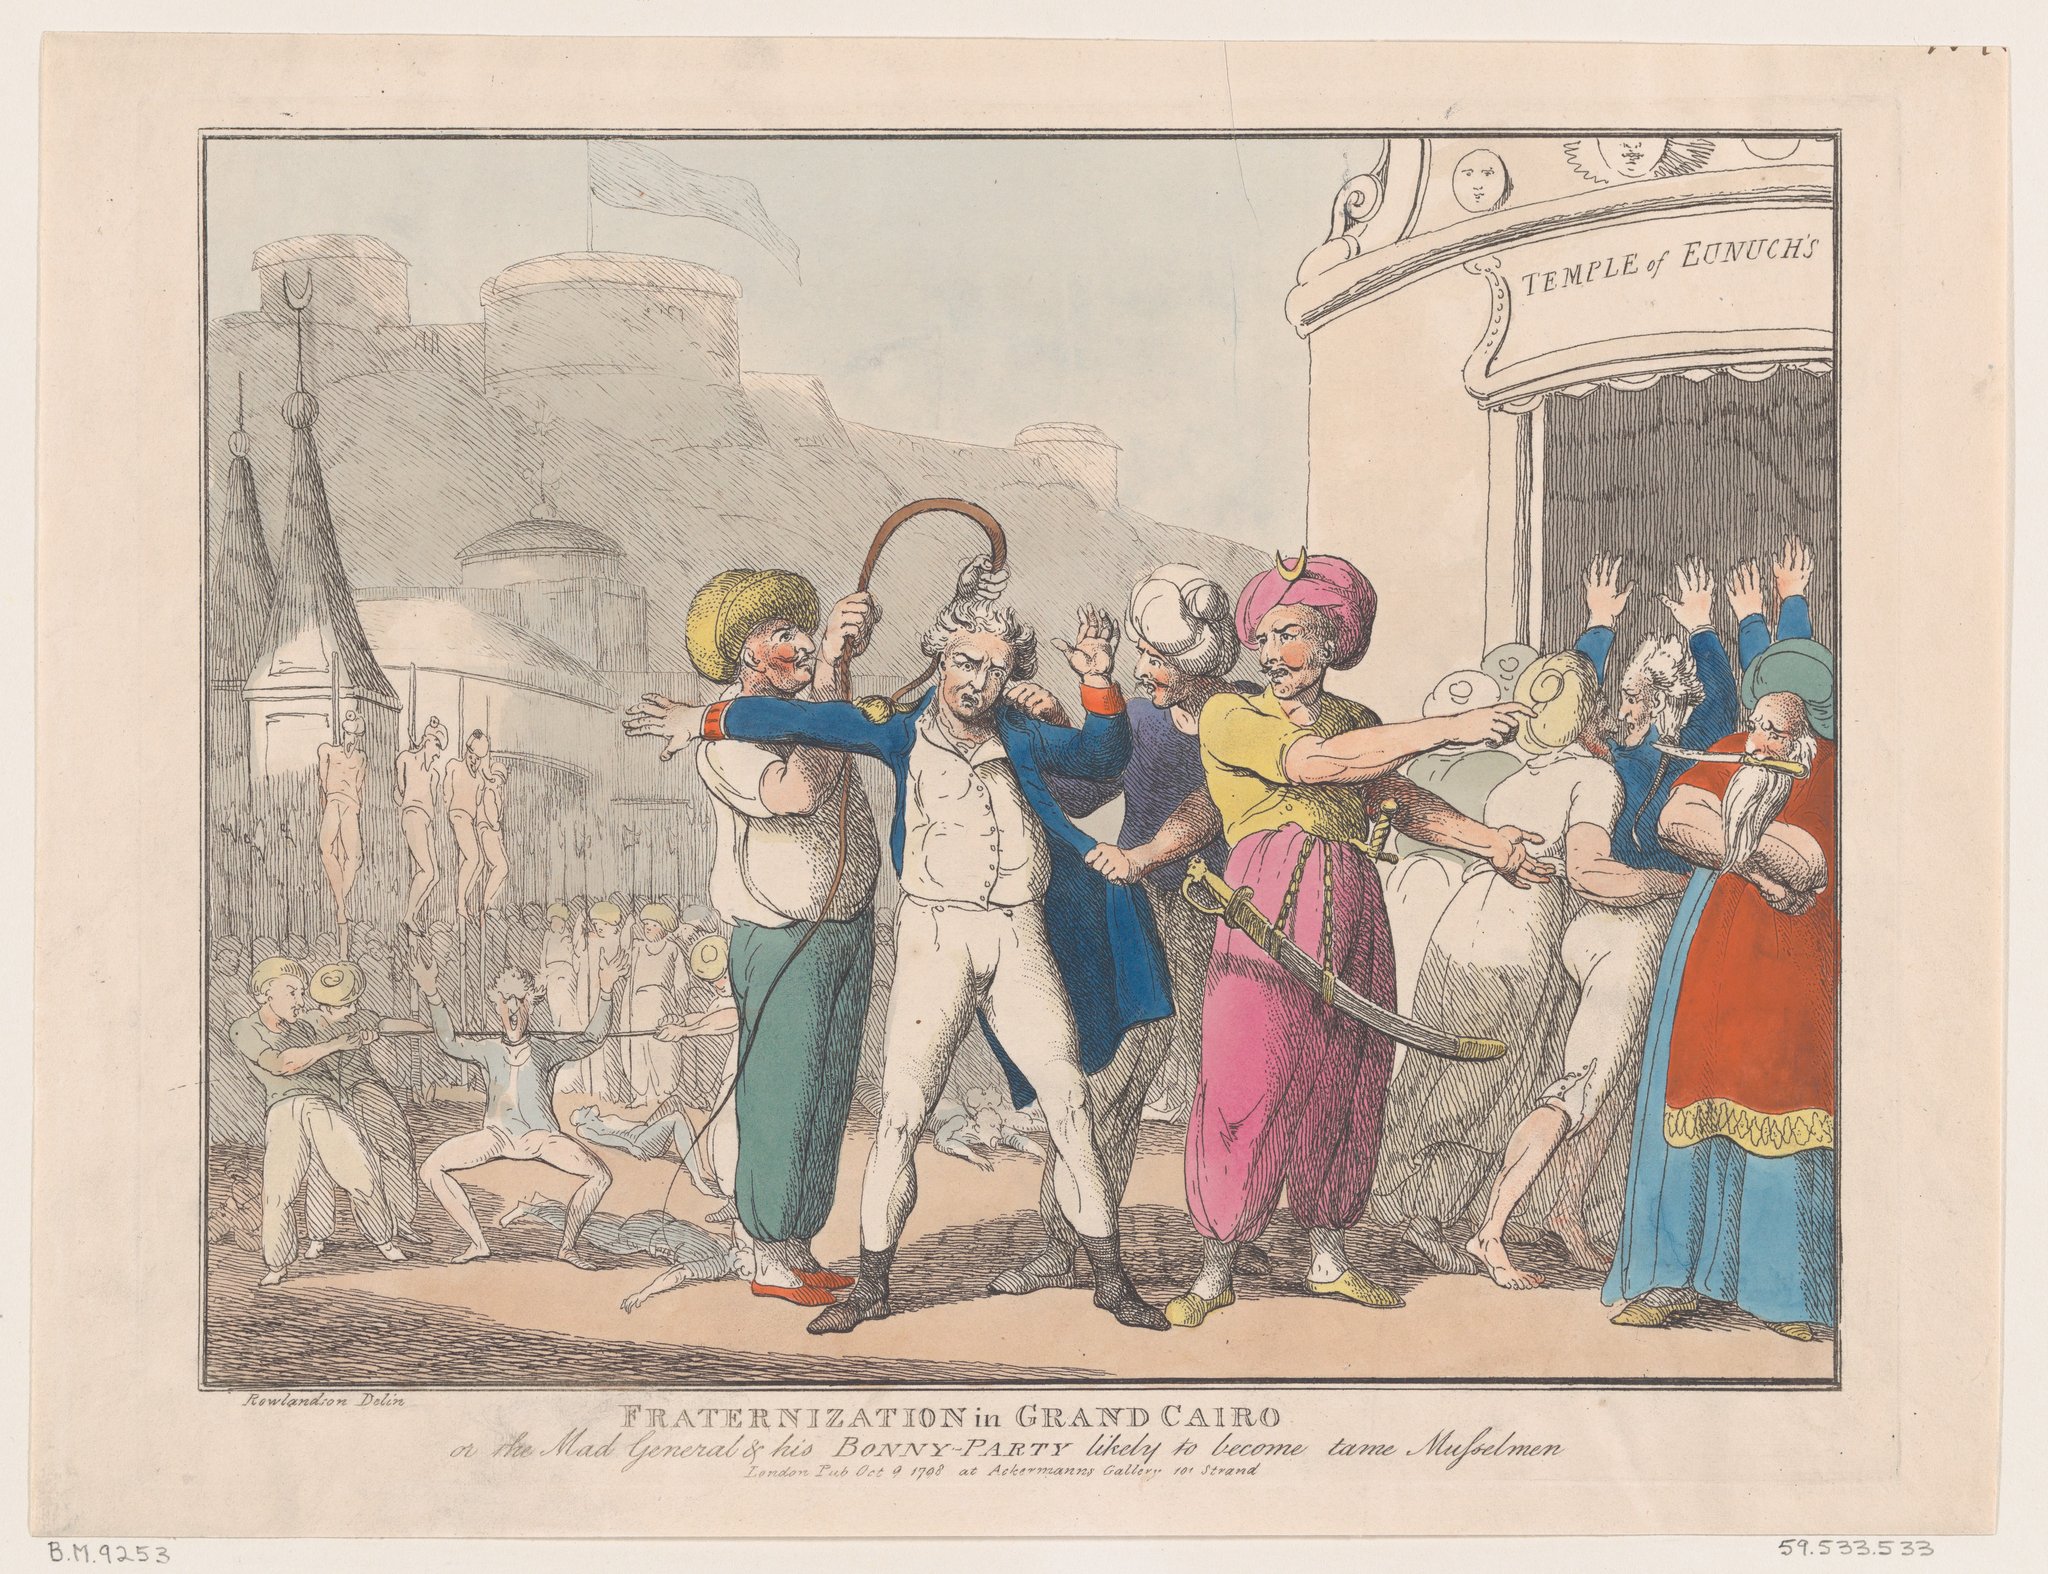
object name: print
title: Fraternization in Grand Cairo, or The Made General & his Bonny Party Likely to Become Tame Musselmen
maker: thomas rowlandson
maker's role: artist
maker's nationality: british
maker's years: 1757-1827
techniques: aquatint, etching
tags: men,women,punishment,generals